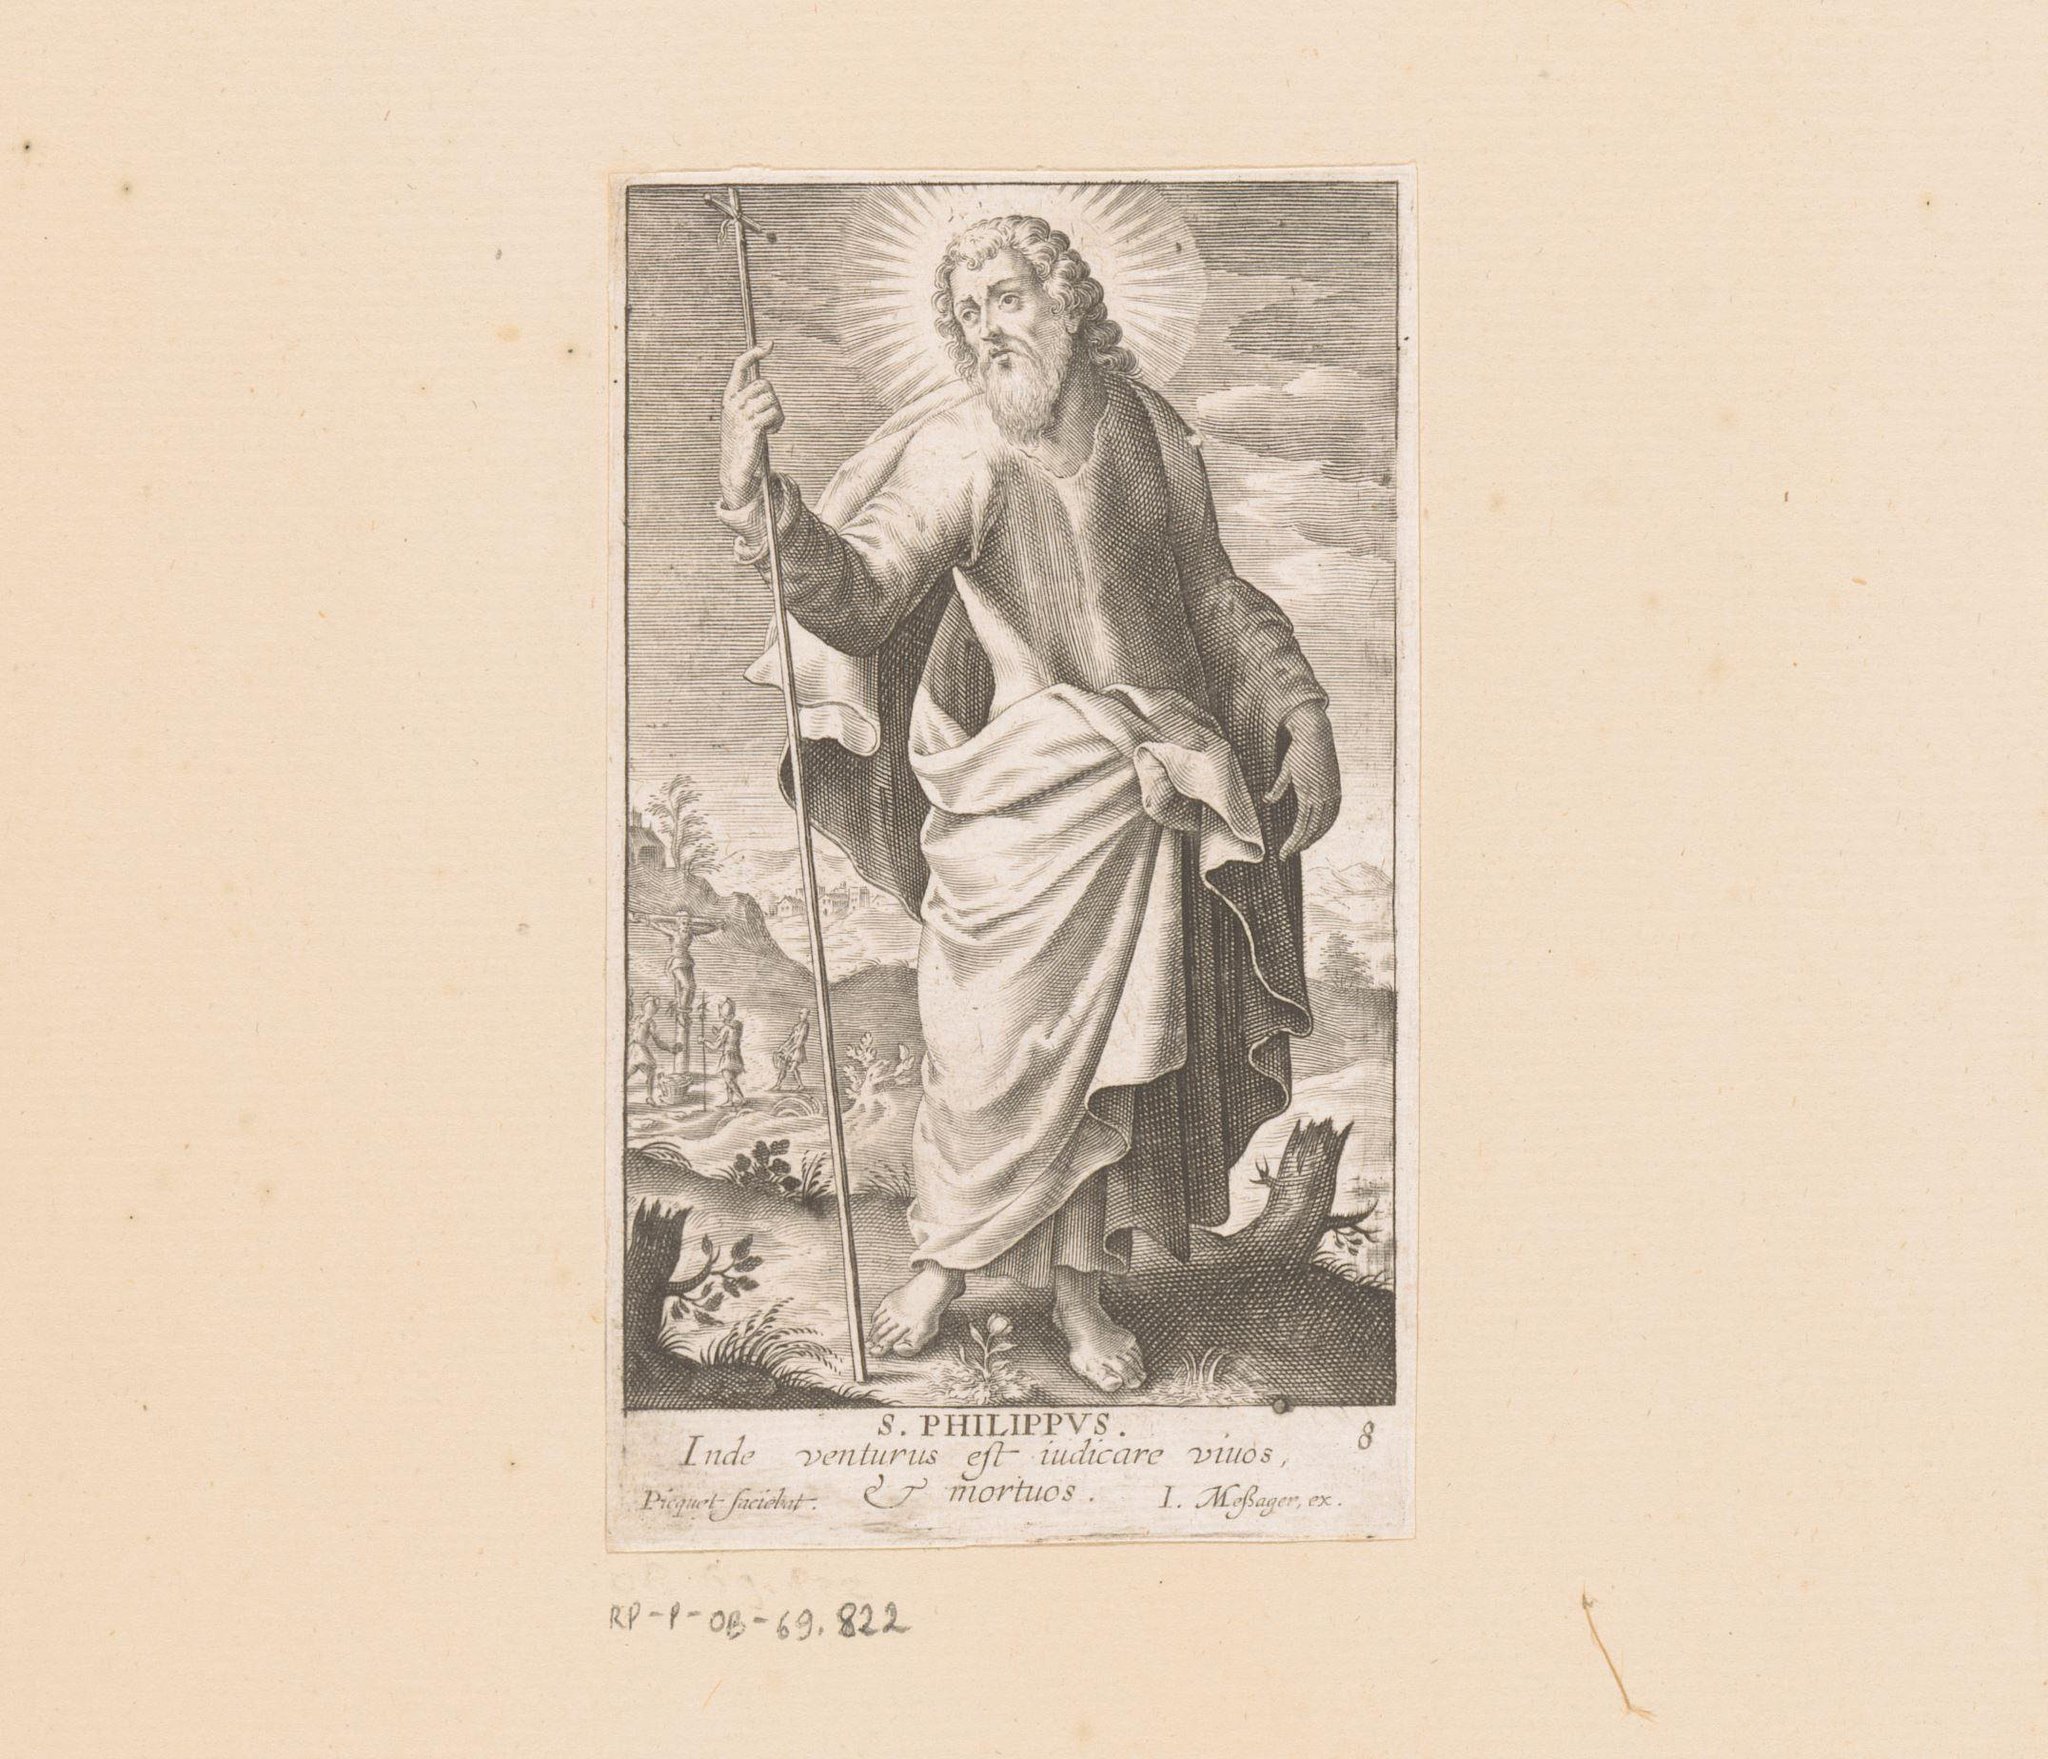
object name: print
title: S. Philippus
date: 1608-1649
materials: paper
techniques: engraving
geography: paris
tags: the apostle philip; possible attributes: book, cross, dish with snake, lance, scroll, stone, sword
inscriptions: collector's mark: Lugt 240